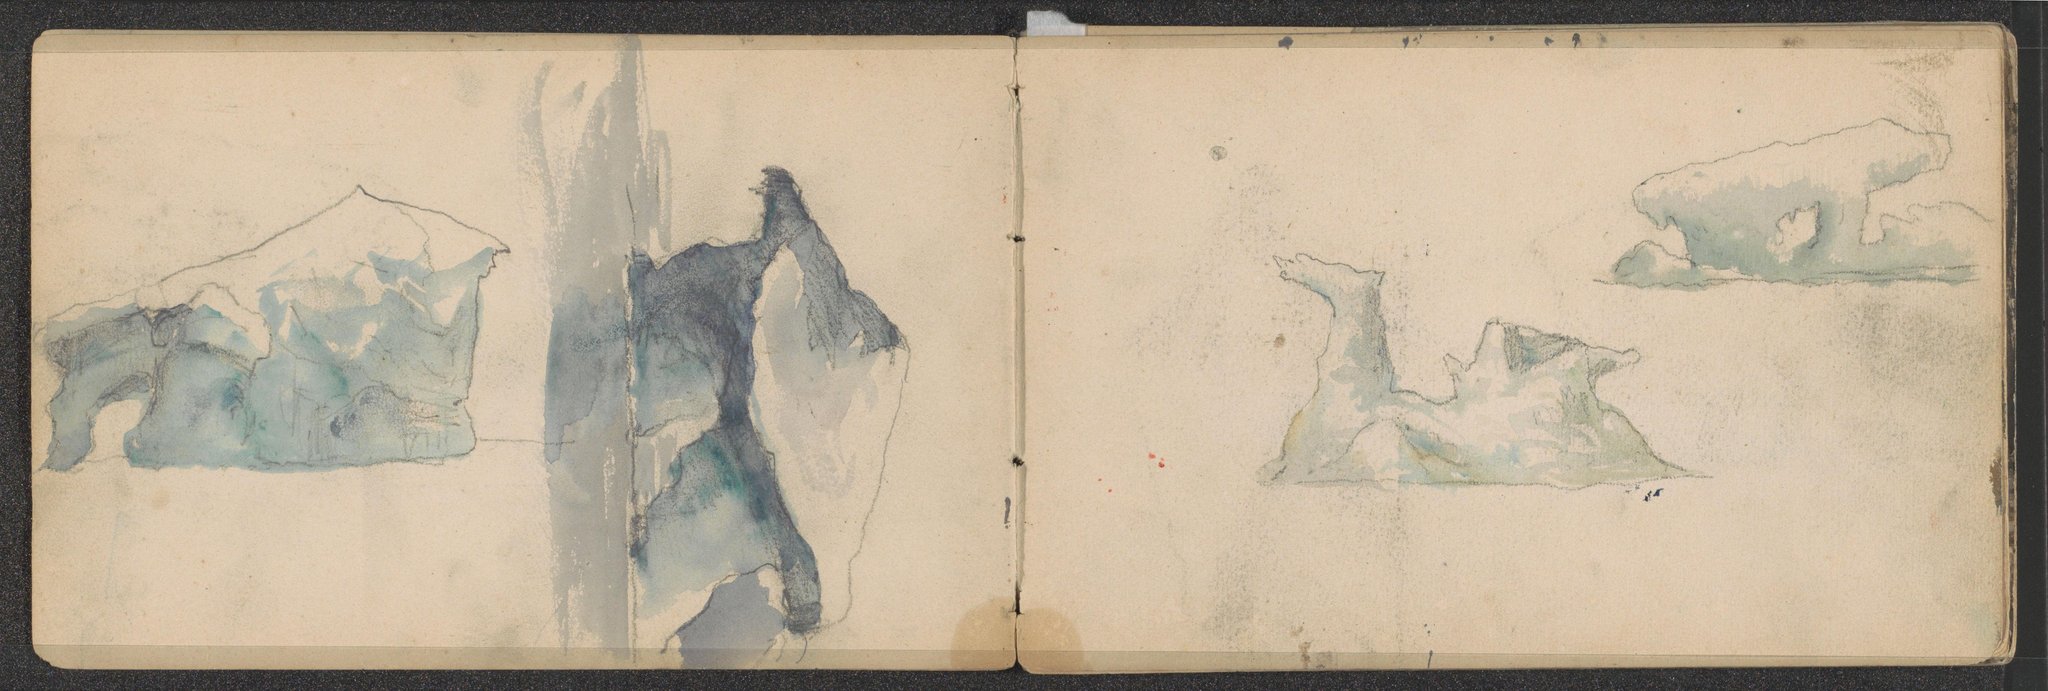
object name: sketchbook leaf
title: IJsschotsen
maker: louis apol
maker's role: draughtsman, painter, print maker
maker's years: 1850-1936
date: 1880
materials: chalk, paper, watercolor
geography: barentsz sea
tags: iceberg, drift ice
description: Blad 5 recto uit een schetsboek met 35 bladen betekend tijdens de expeditie naar Nova Zembla in 1880.